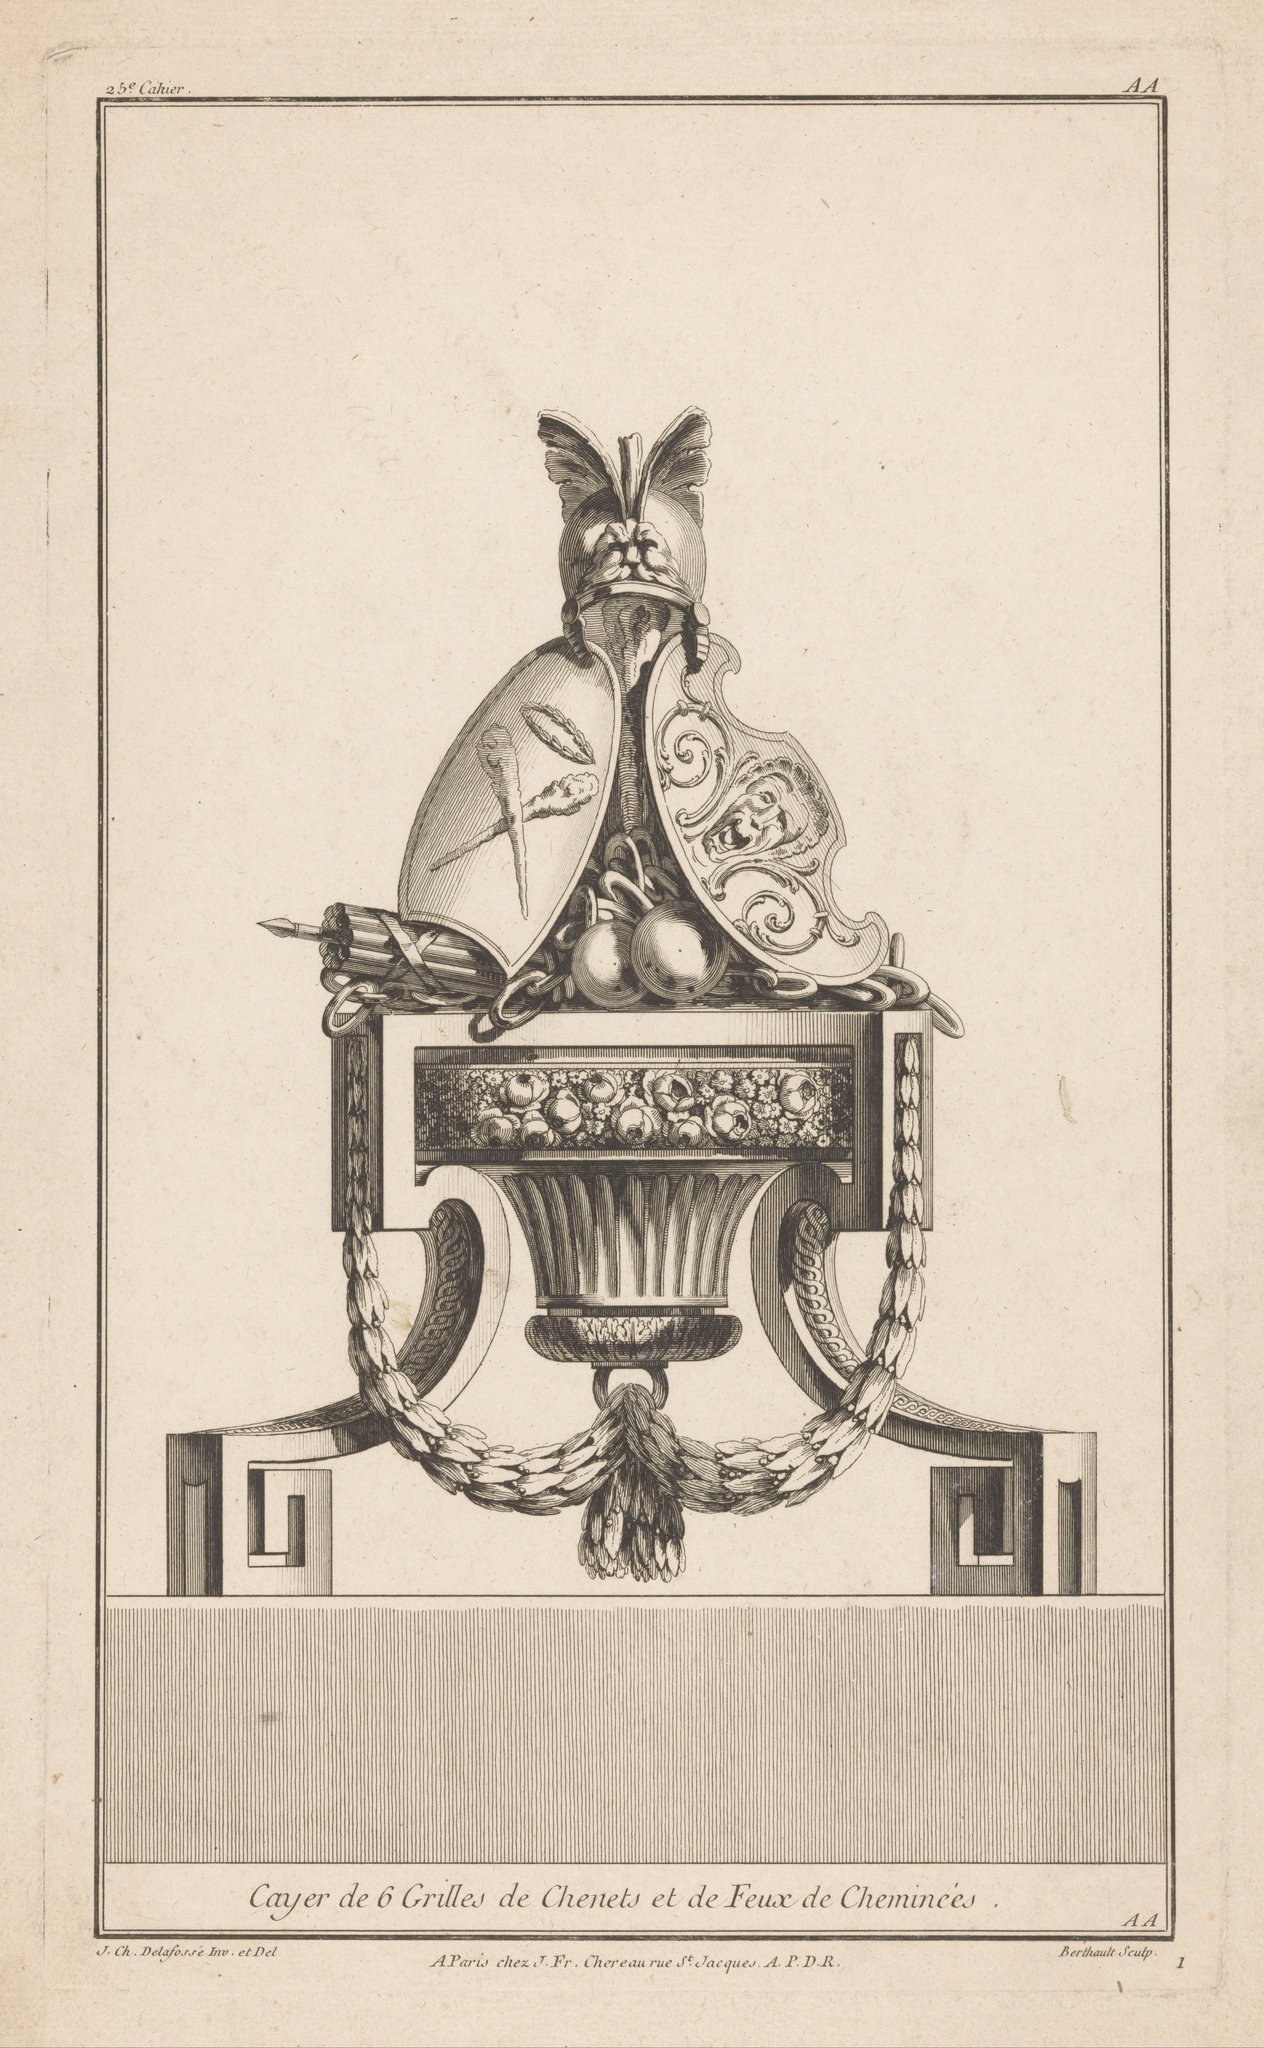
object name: titelprent, frontispice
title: IIe Volume De l'Oeuvre de J. Ch. Delafosse (...)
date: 1771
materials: paper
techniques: engraving, etching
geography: paris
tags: helmet, protective weapons: shield, andiron, fire-dog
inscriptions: collector's mark: Lugt 2228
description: Een geornamenteerde vuurbok met een helm, schilden, wapens en guirlandes.